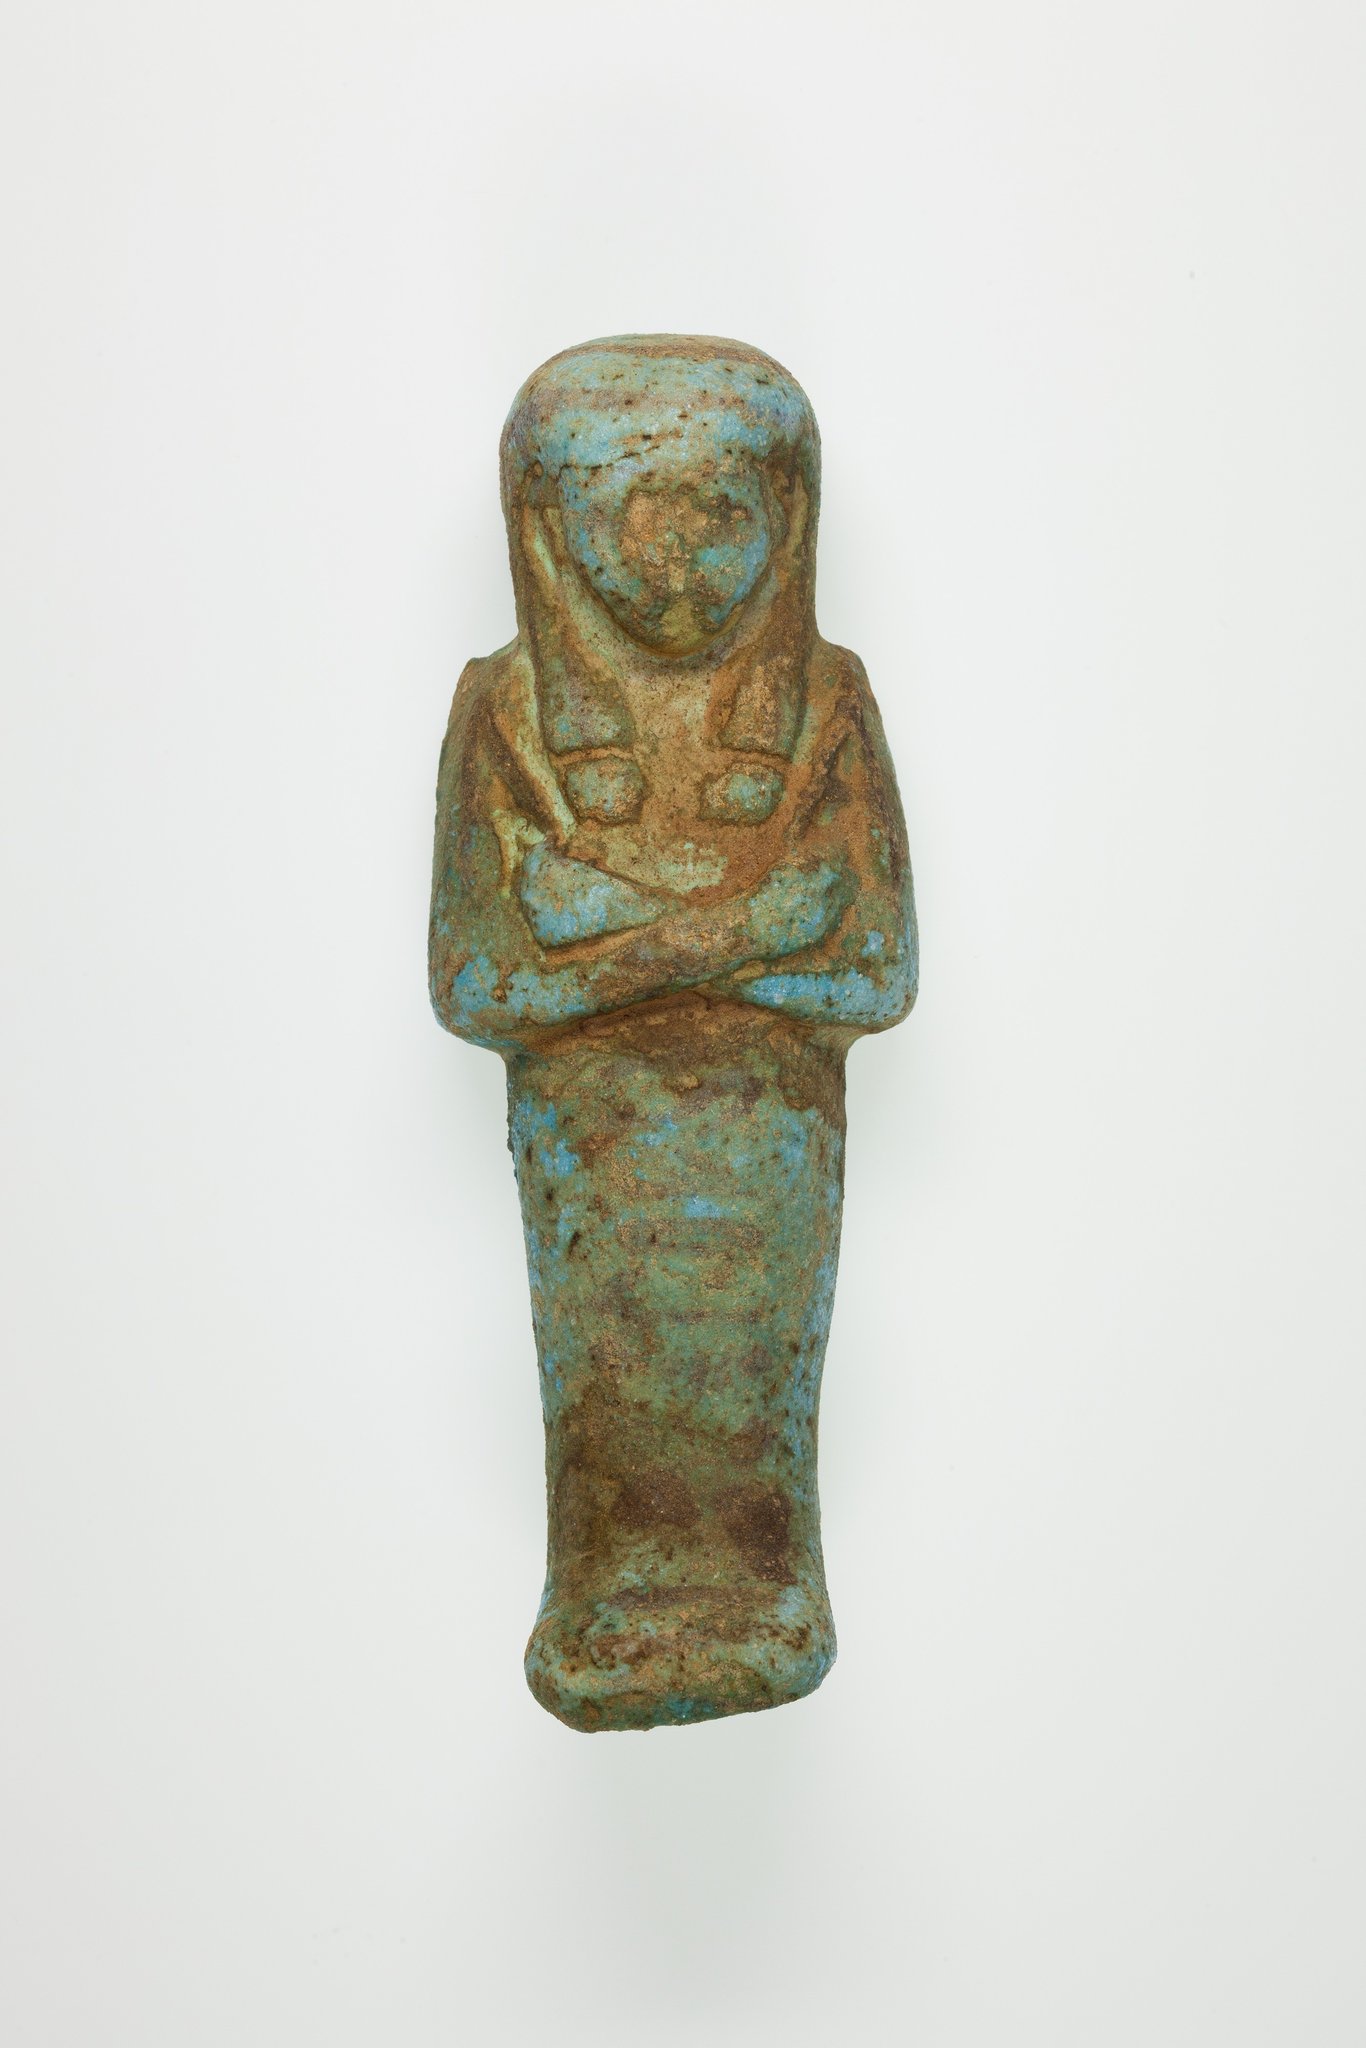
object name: shabti, henettawy c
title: Worker Shabti of Henettawy (C), Daughter of Isetemkheb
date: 990-970 BCE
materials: faience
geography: egypt